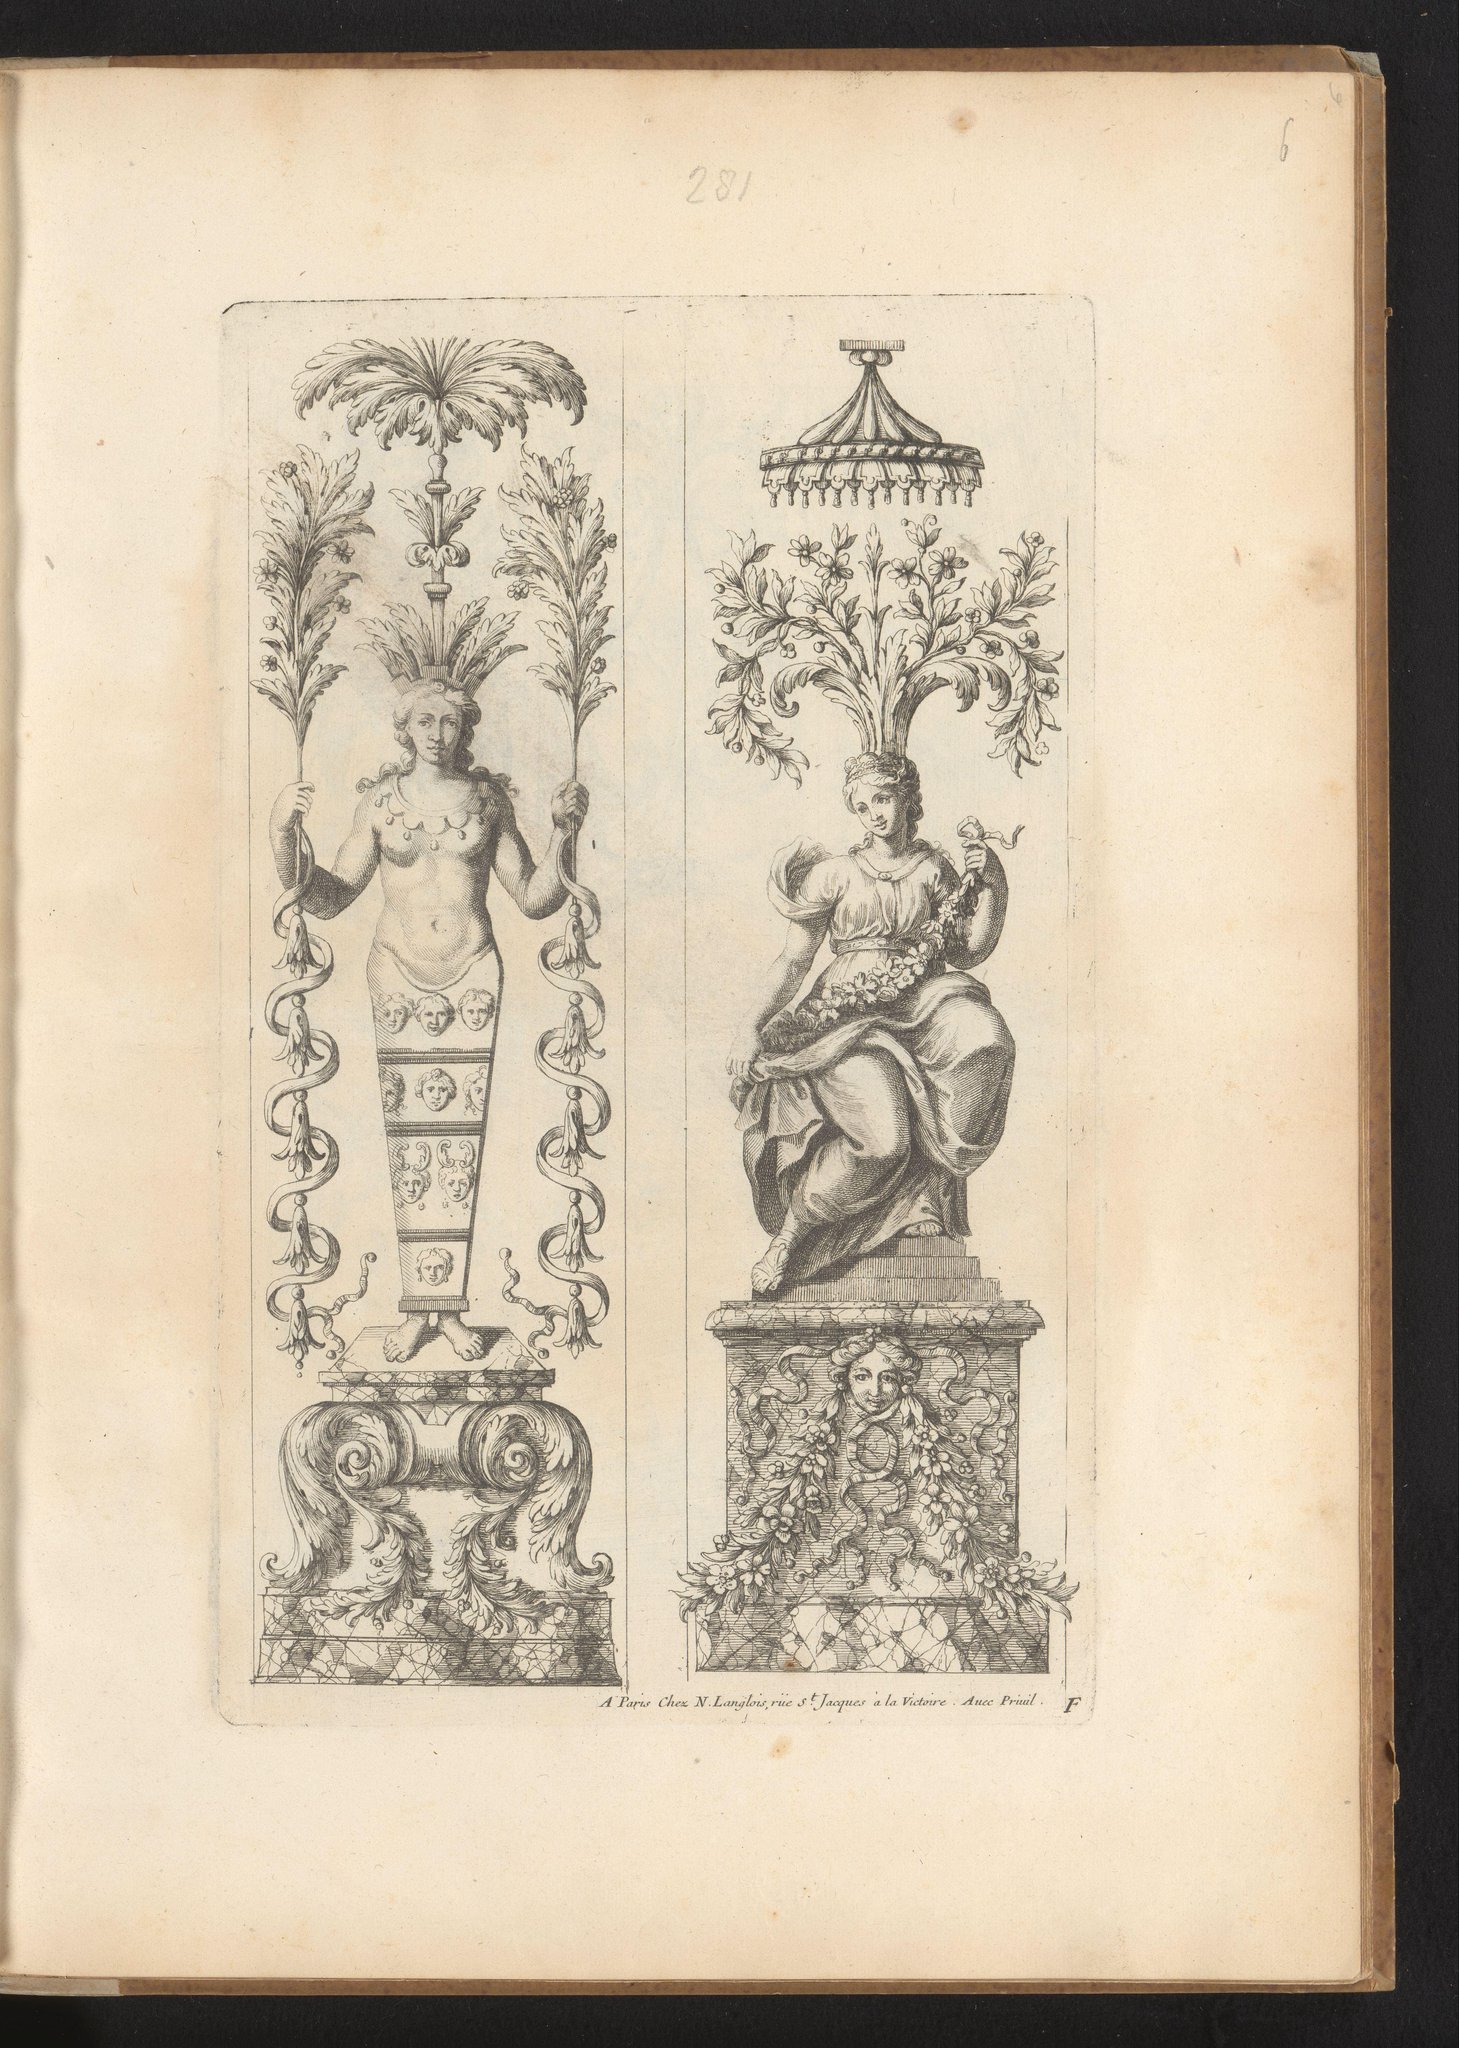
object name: album leaf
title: Ornemens des Appartemens de la Reine au Vieux Louvre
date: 1650-1703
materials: paper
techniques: engraving, etching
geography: paris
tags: caryatids ~ architecture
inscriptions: collector's mark: Lugt 2228a, collector's mark: Lugt 2760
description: Rechtsonder genummerd met de letter F. Deze prent maakt deel uit van een album.